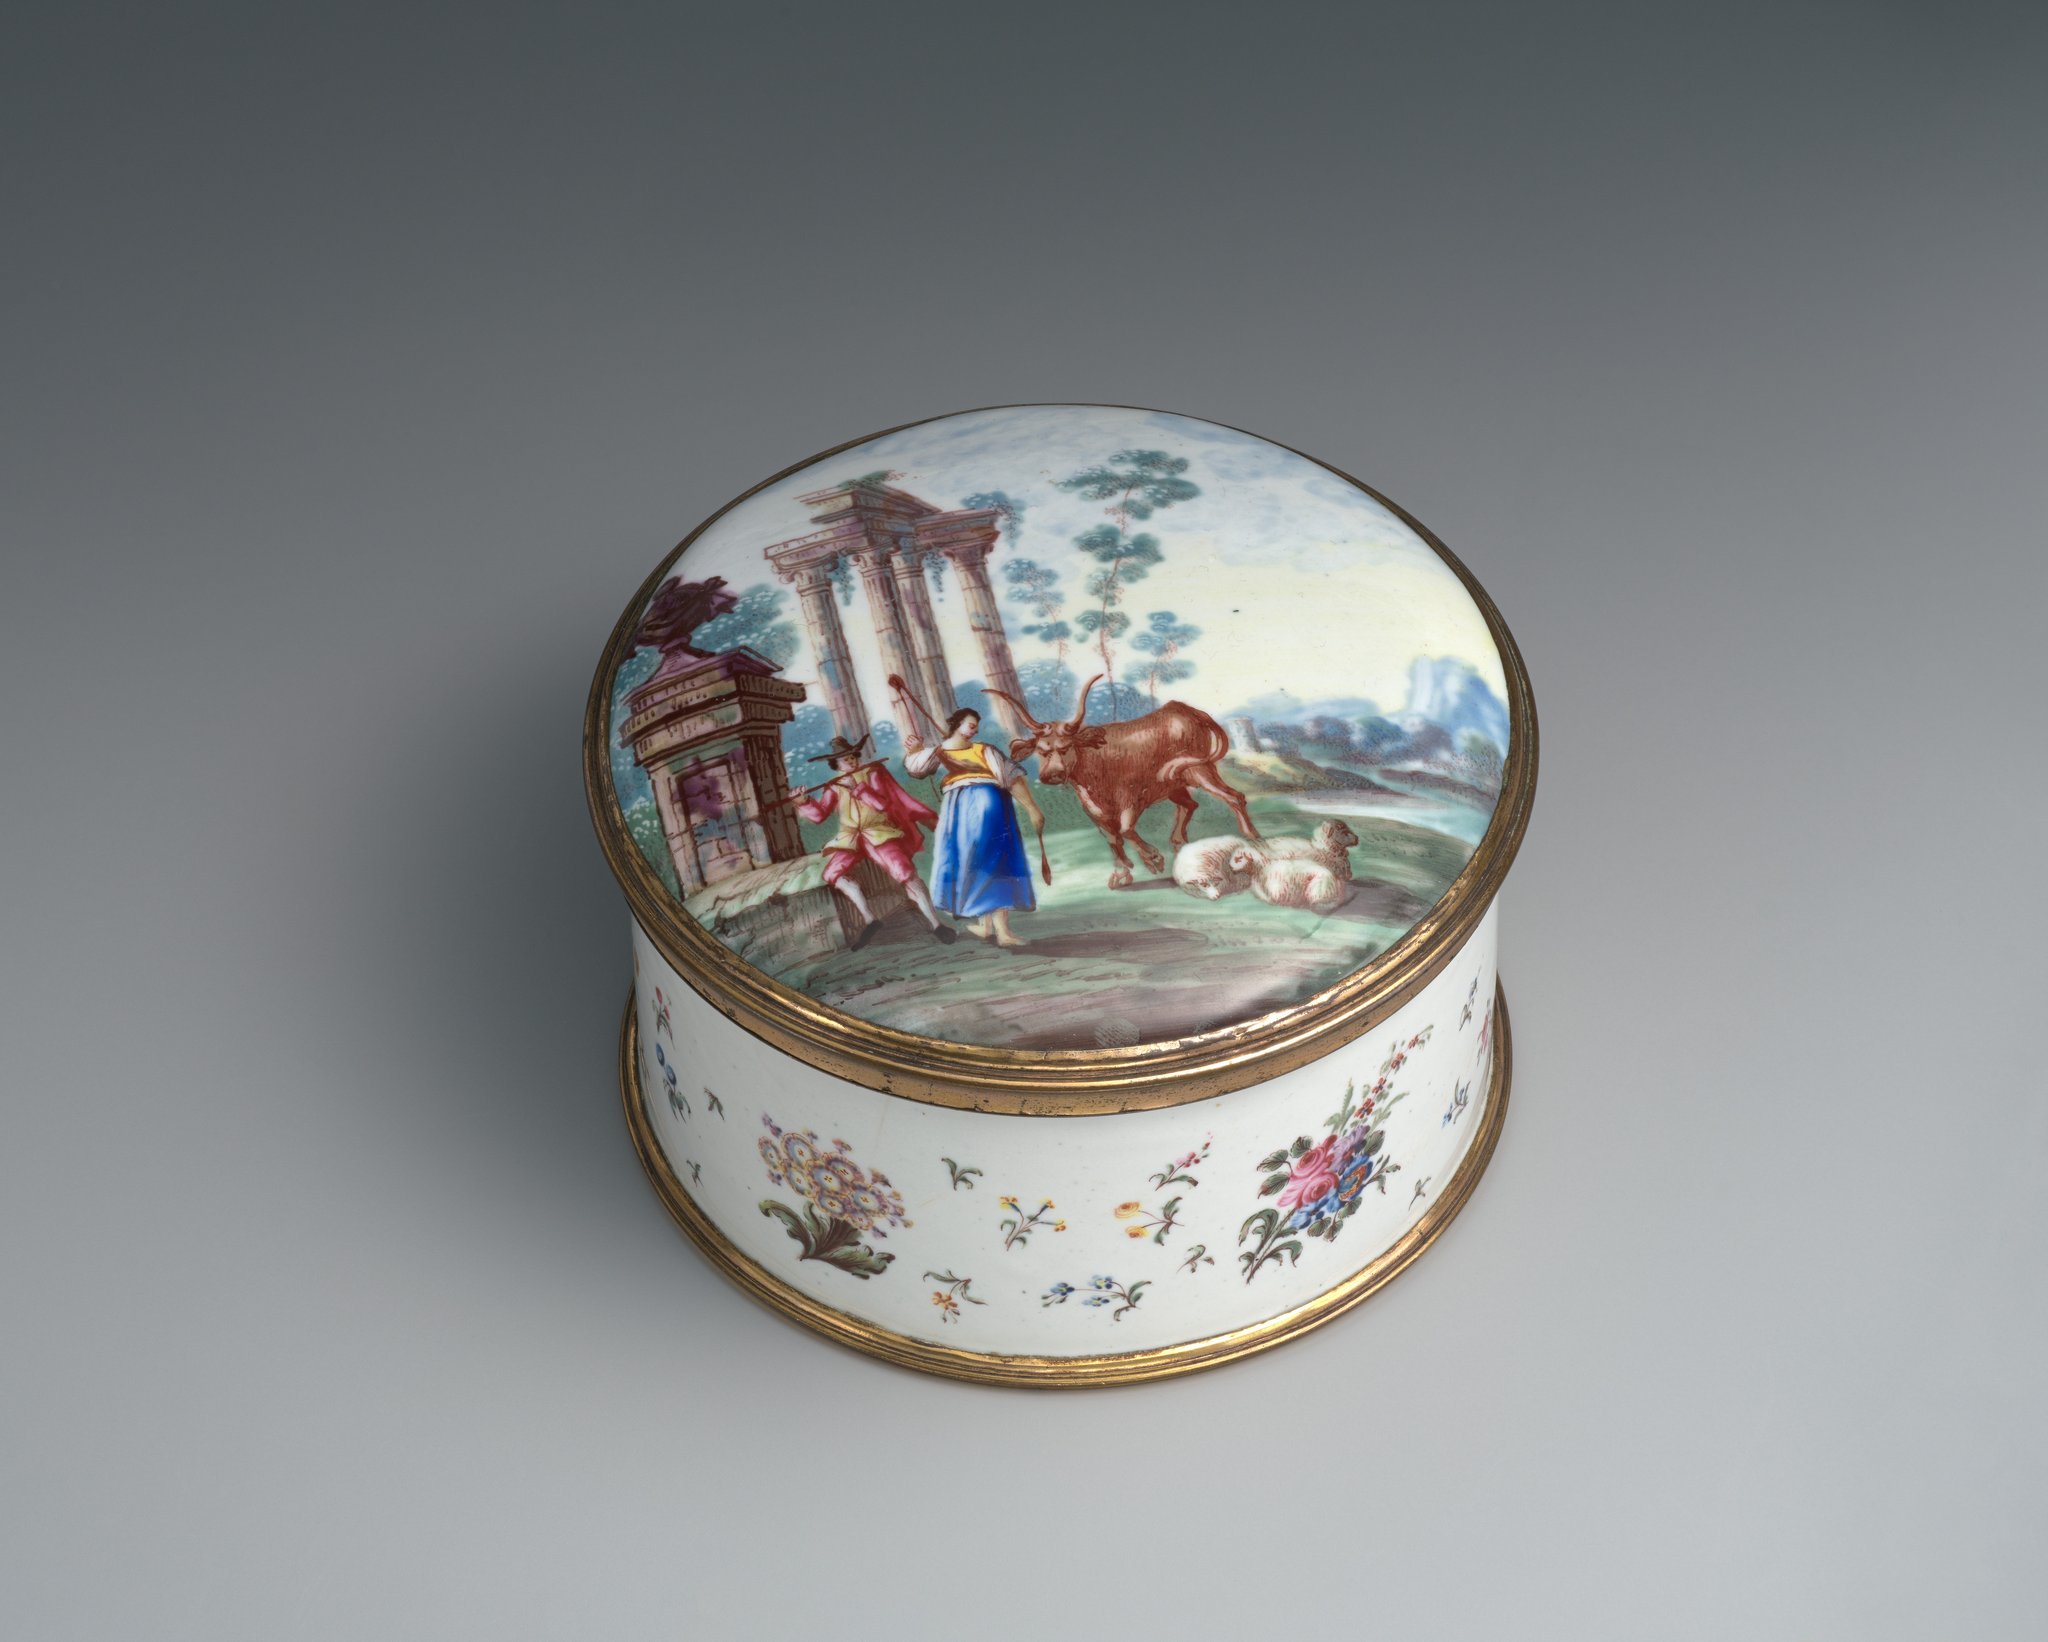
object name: box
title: Toilet box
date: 1750-1760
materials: copper, enamel